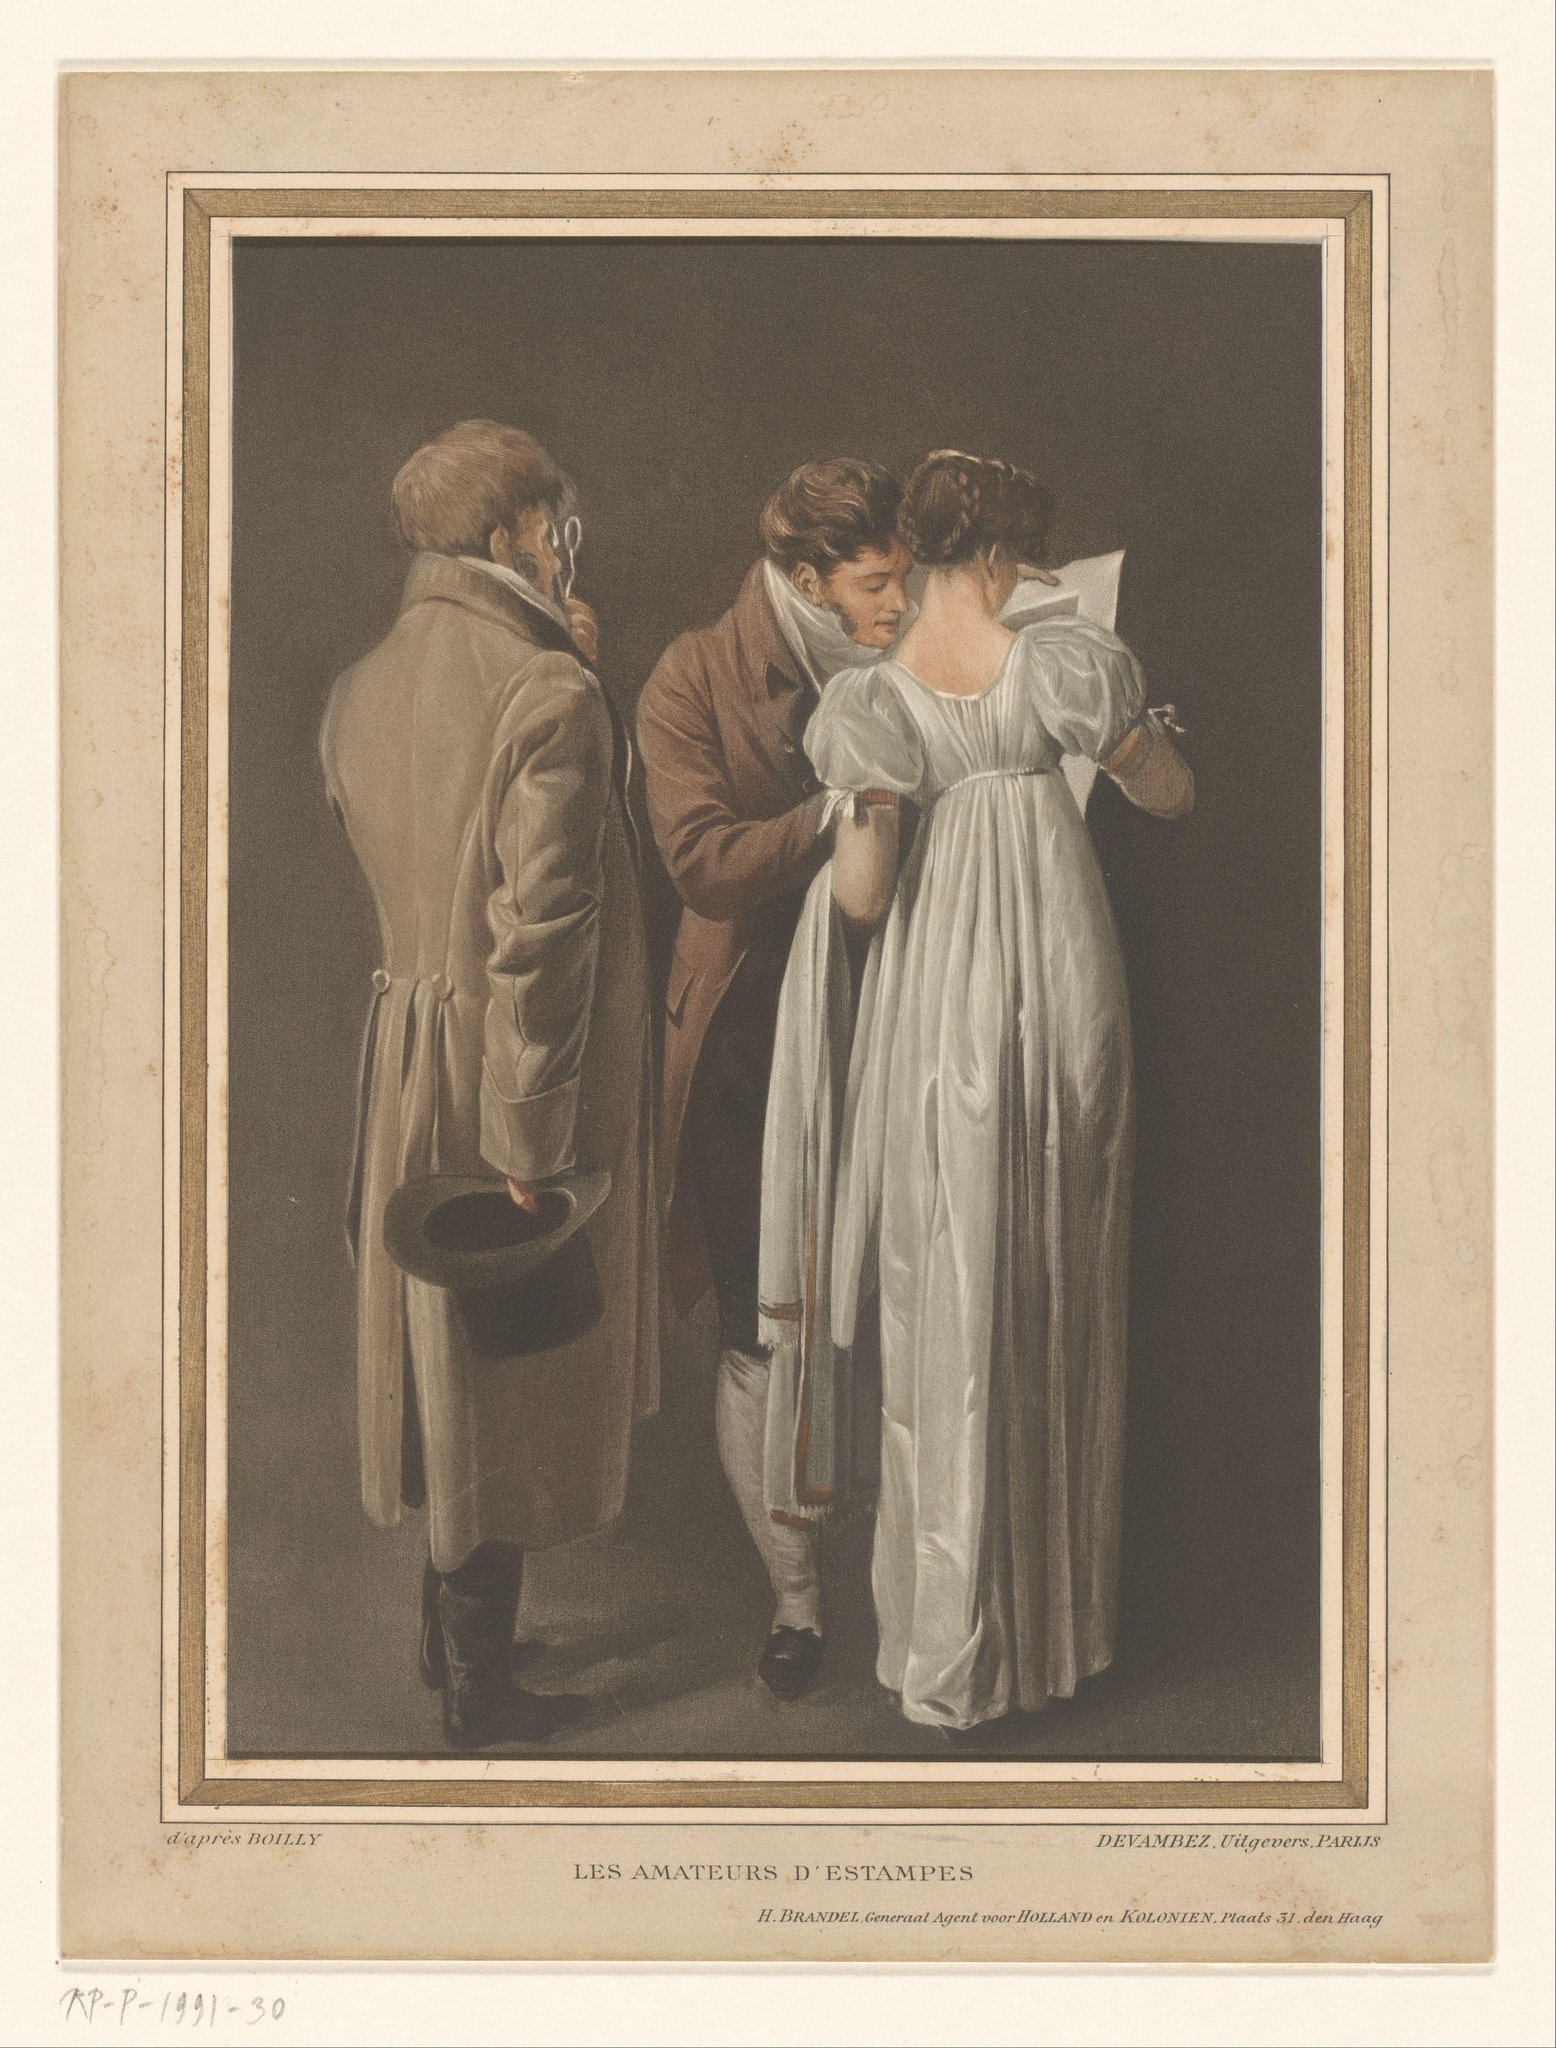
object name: print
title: Les Amateurs d'estampes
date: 1810-1900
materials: paper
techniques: engraving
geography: the hague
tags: print, e.g.: engraving, etching, lithograph, temporary exhibition, 'salon'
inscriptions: collector's mark: Lugt 2228, title: ‘Les amateurs d'estampes’, collector's mark: Lugt 2760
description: Het schilderij van Boilly bevindt zich in de collectie van het Musée du Louvre te Parijs, inv.nr. R.F. 1721.